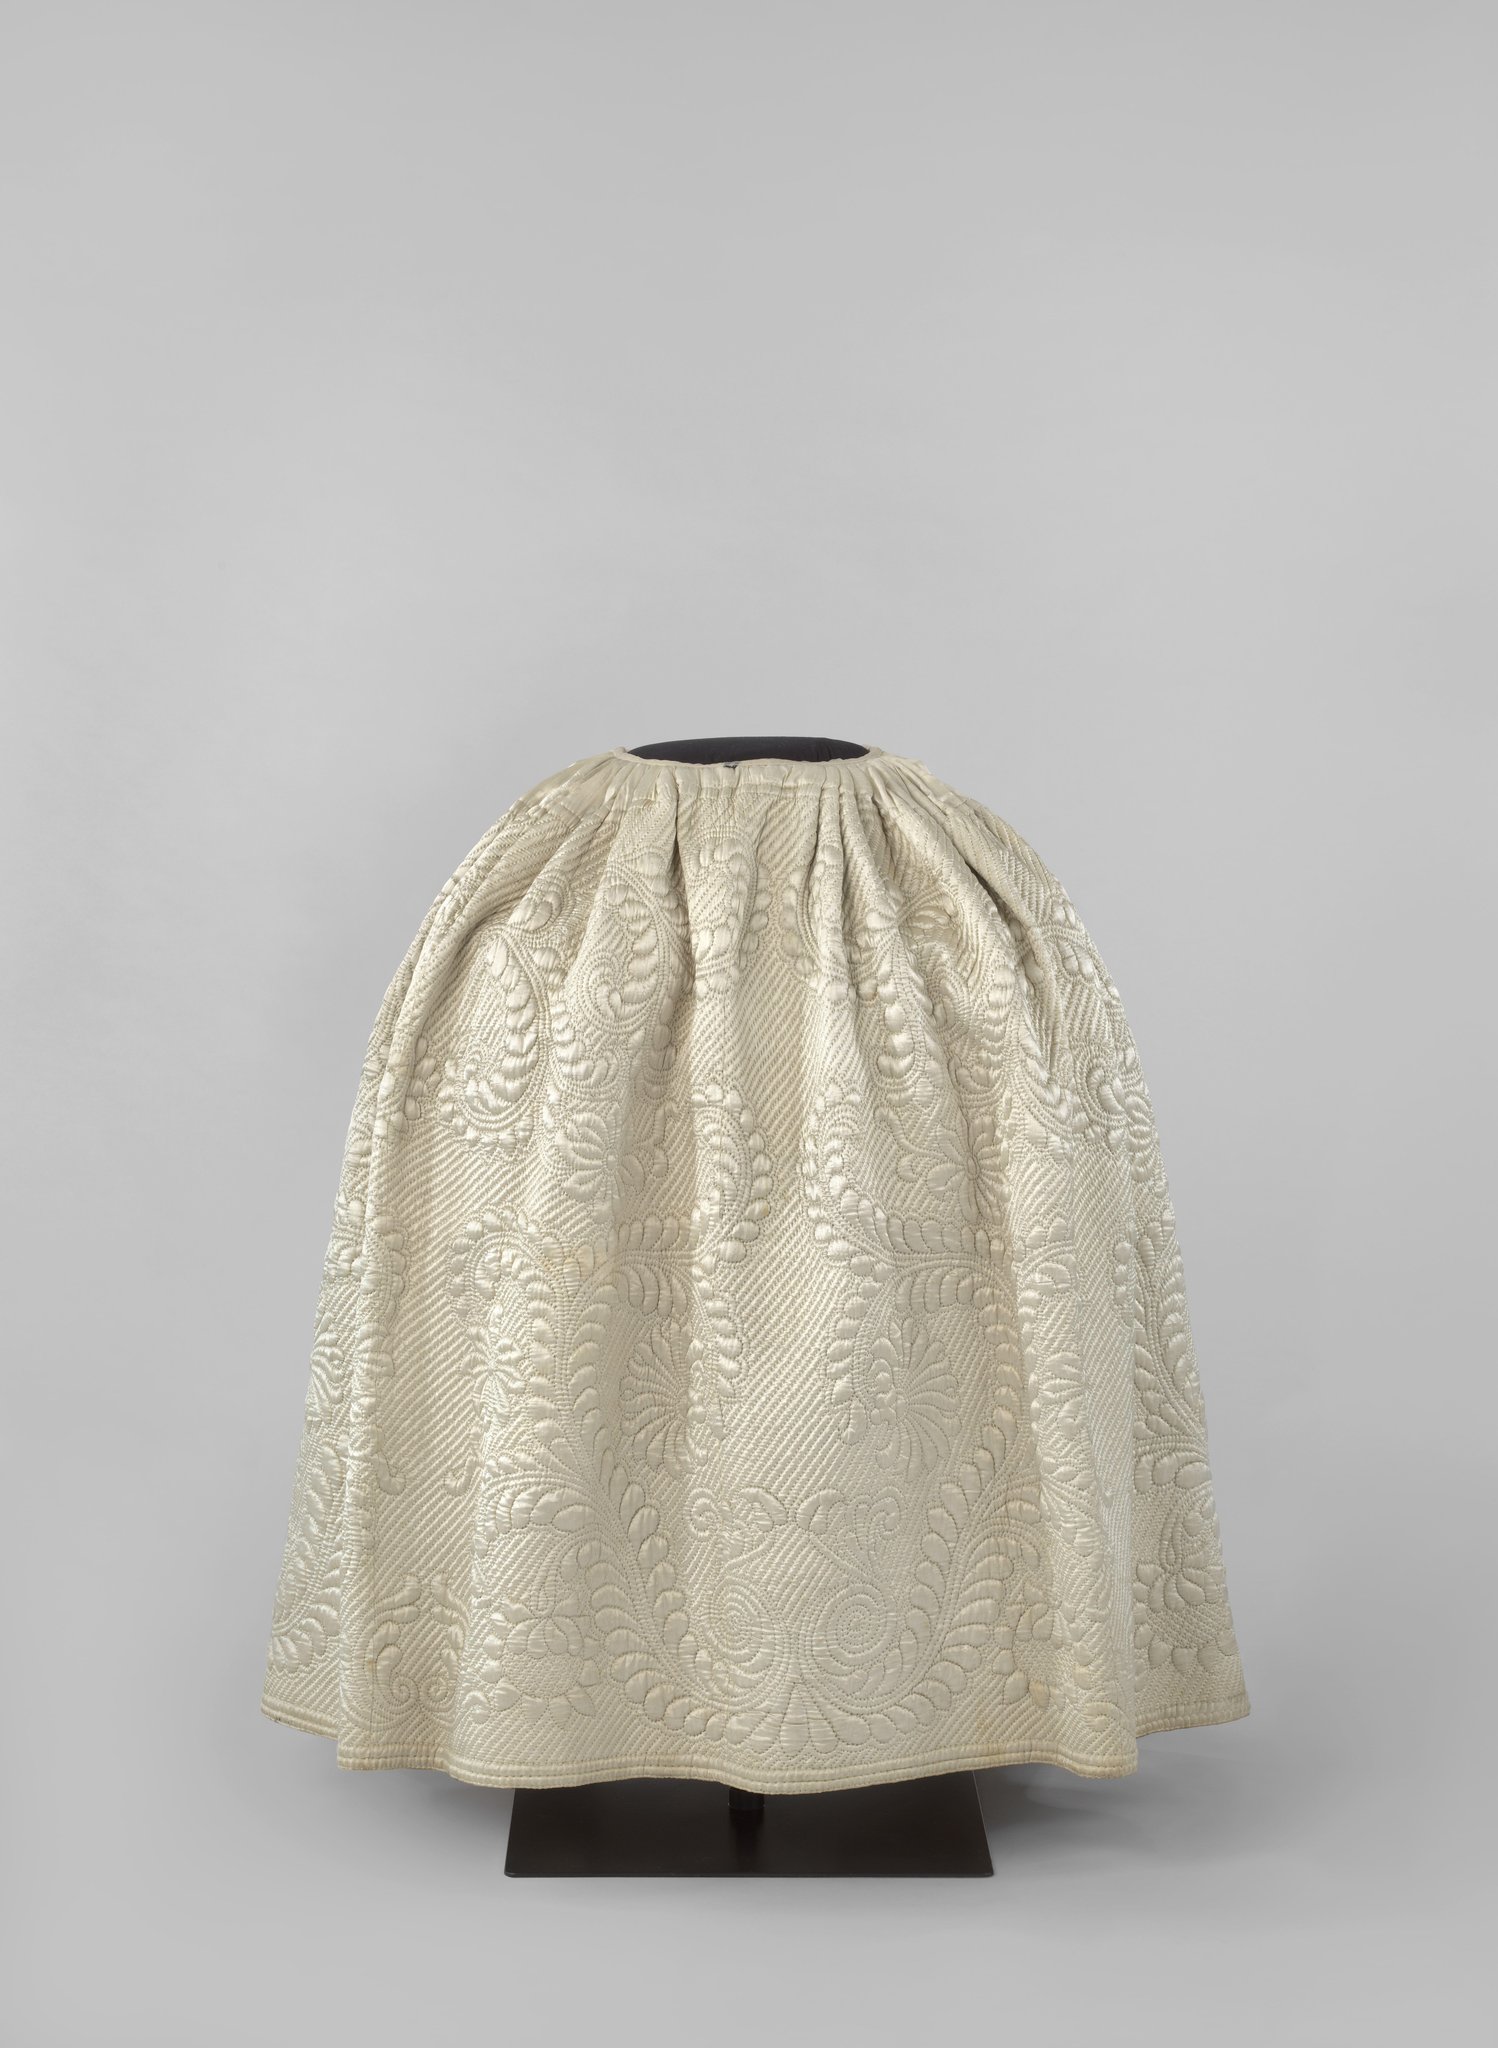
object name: main garment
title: Rok met twee zijsplitten en witte linnen voering van gewatteerd en doorgestikt wit satijn; de rok is rondom geplooid met glad stuk middenvoor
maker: Anonymous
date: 1700-1800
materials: linen, textile, silk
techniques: embroidered, quilting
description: Witsatijnen rok, gewatterd en gestikt, zogenaamd Zaans Stikwerk. Gevoerd met wit linnen. Twee zijsplitten. In diepe plooien aan een bandje gezet. Alleen middenvoor een glad stuk.